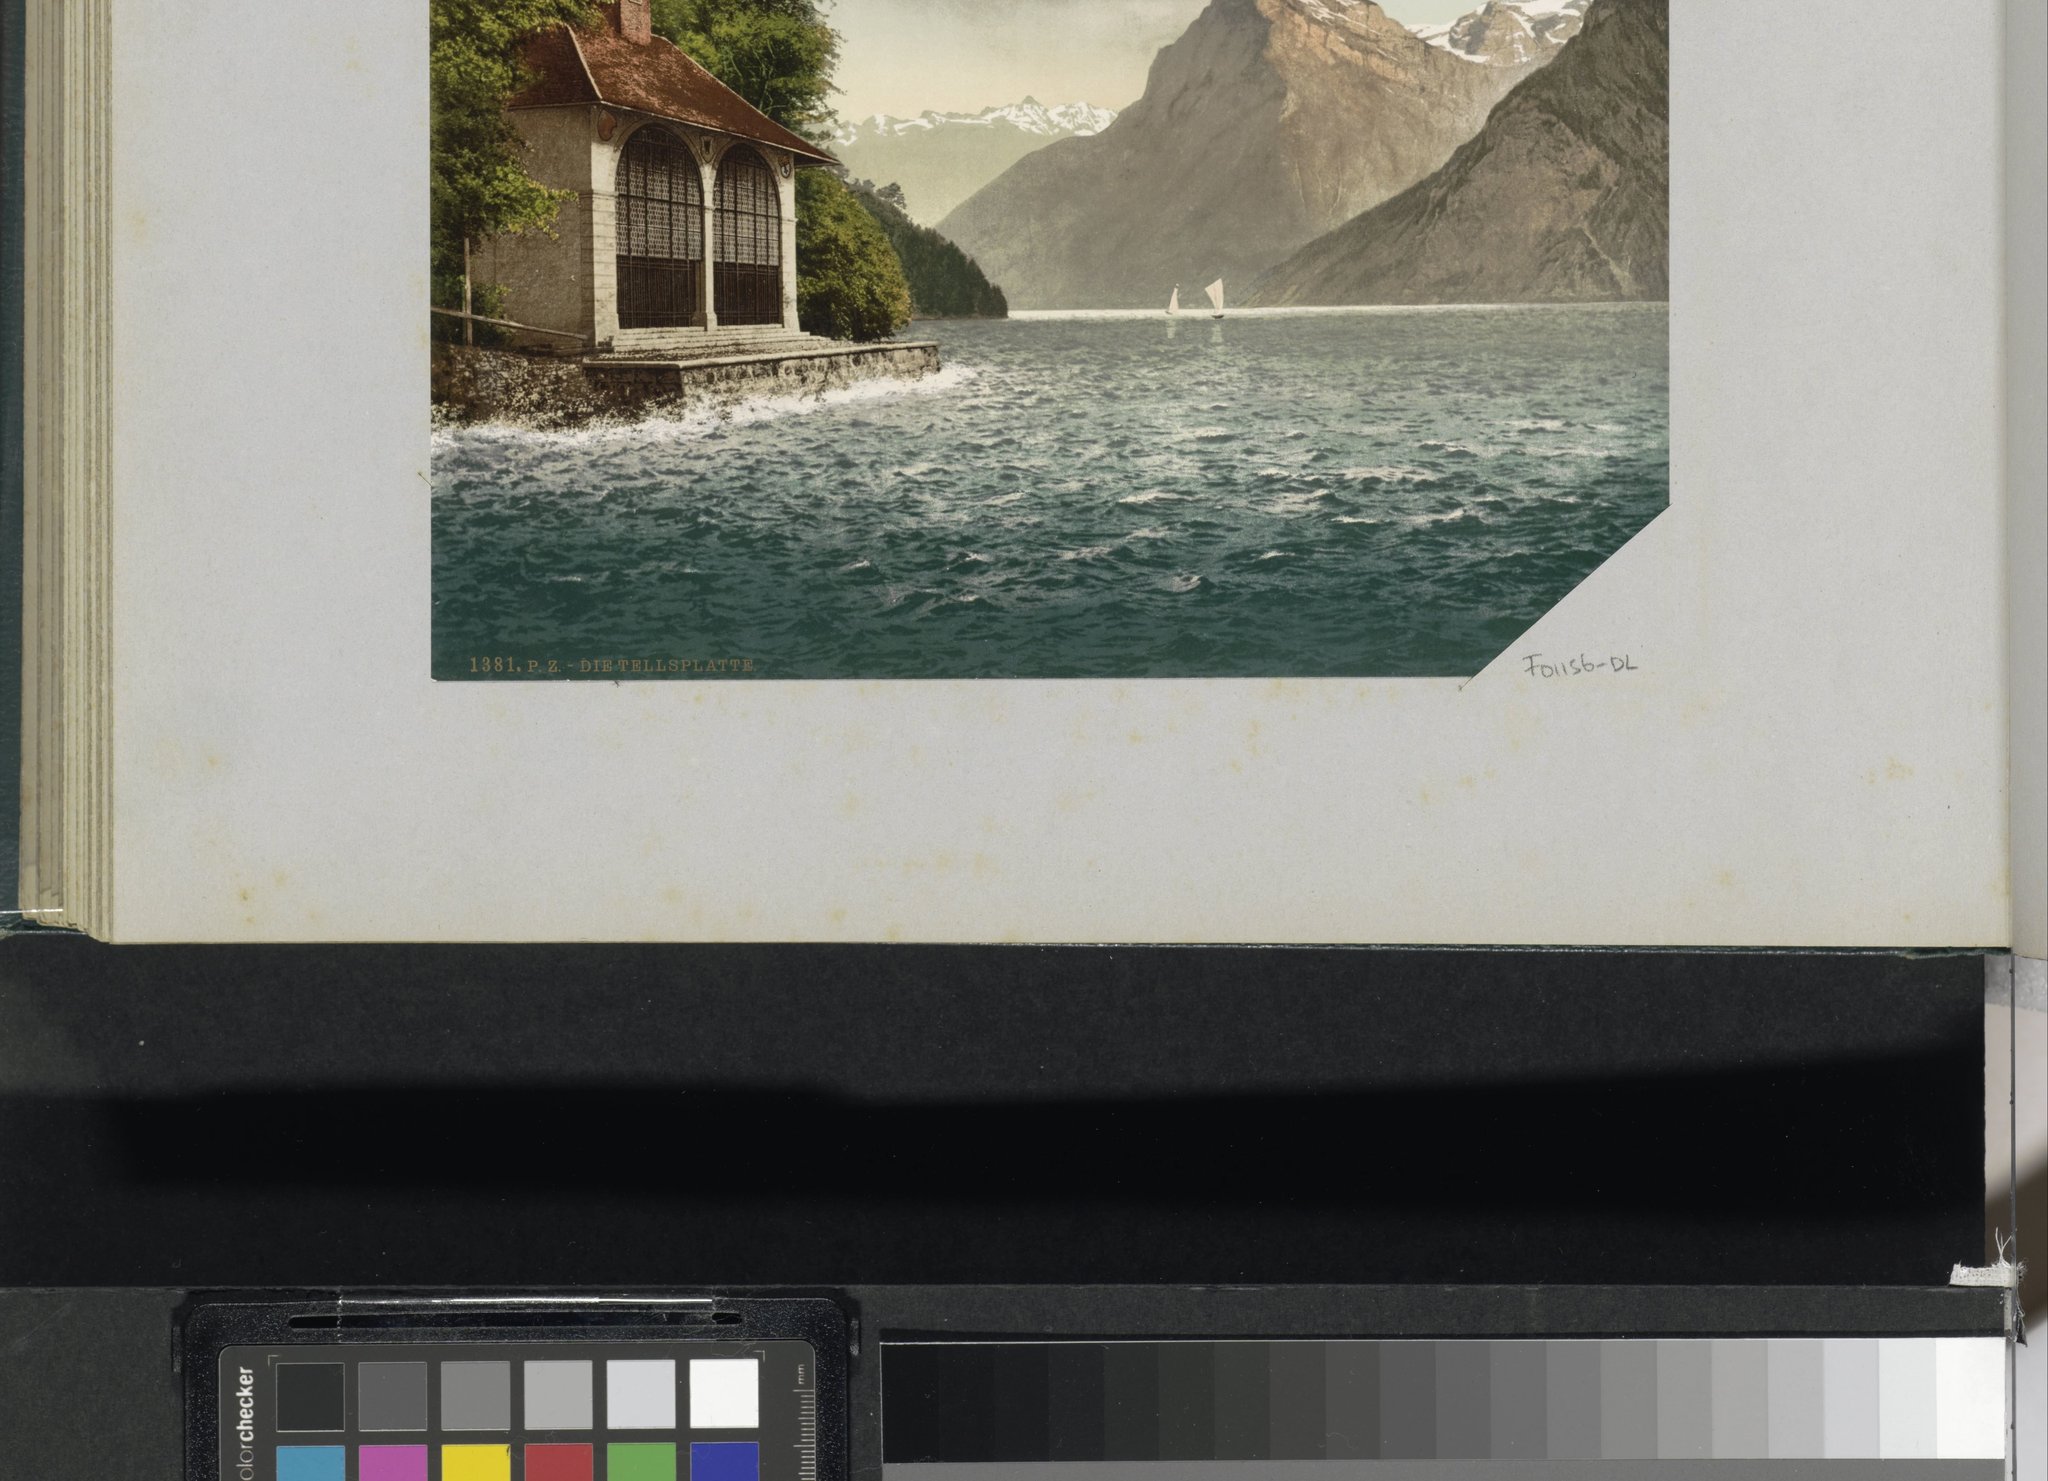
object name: album leaf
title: Gezicht op de Urnersee met de Tellskapelle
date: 1896-1897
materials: paper, photographic process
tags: parts of church exterior and annexes: chapel, lake, mountain-range, snow peaks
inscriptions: inscription: ‘1381. P.Z. - Die Tellsplatte’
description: Deze prent maakt deel uit van een album.